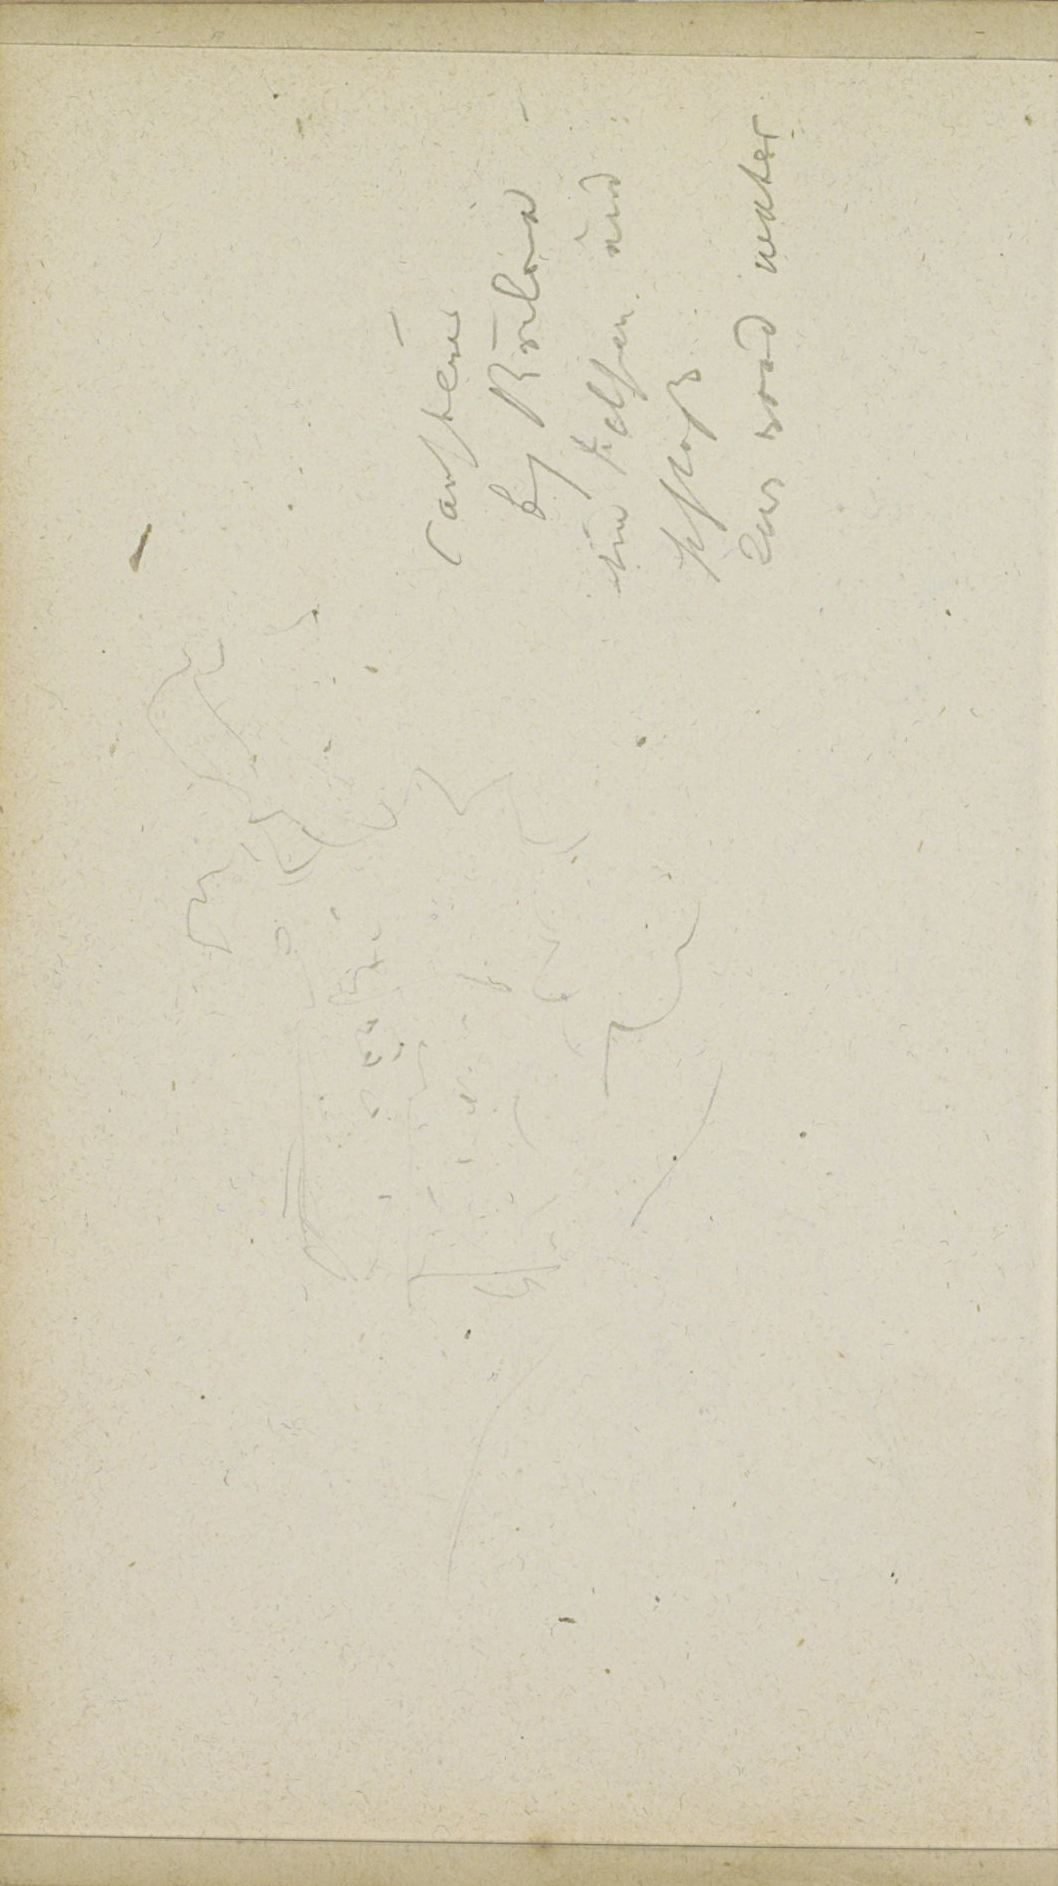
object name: sketchbook leaf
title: Landschap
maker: johannes tavenraat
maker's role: draughtsman, painter, print maker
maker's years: 1809-1881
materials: paper, pencil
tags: landscapes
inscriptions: annotation: ‘ca[...]/ bij Ri[...]l[...]/ in te[...]/ [...]oss/ [...] water’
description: Blad 20 verso uit een schetsboek met 88 bladen.